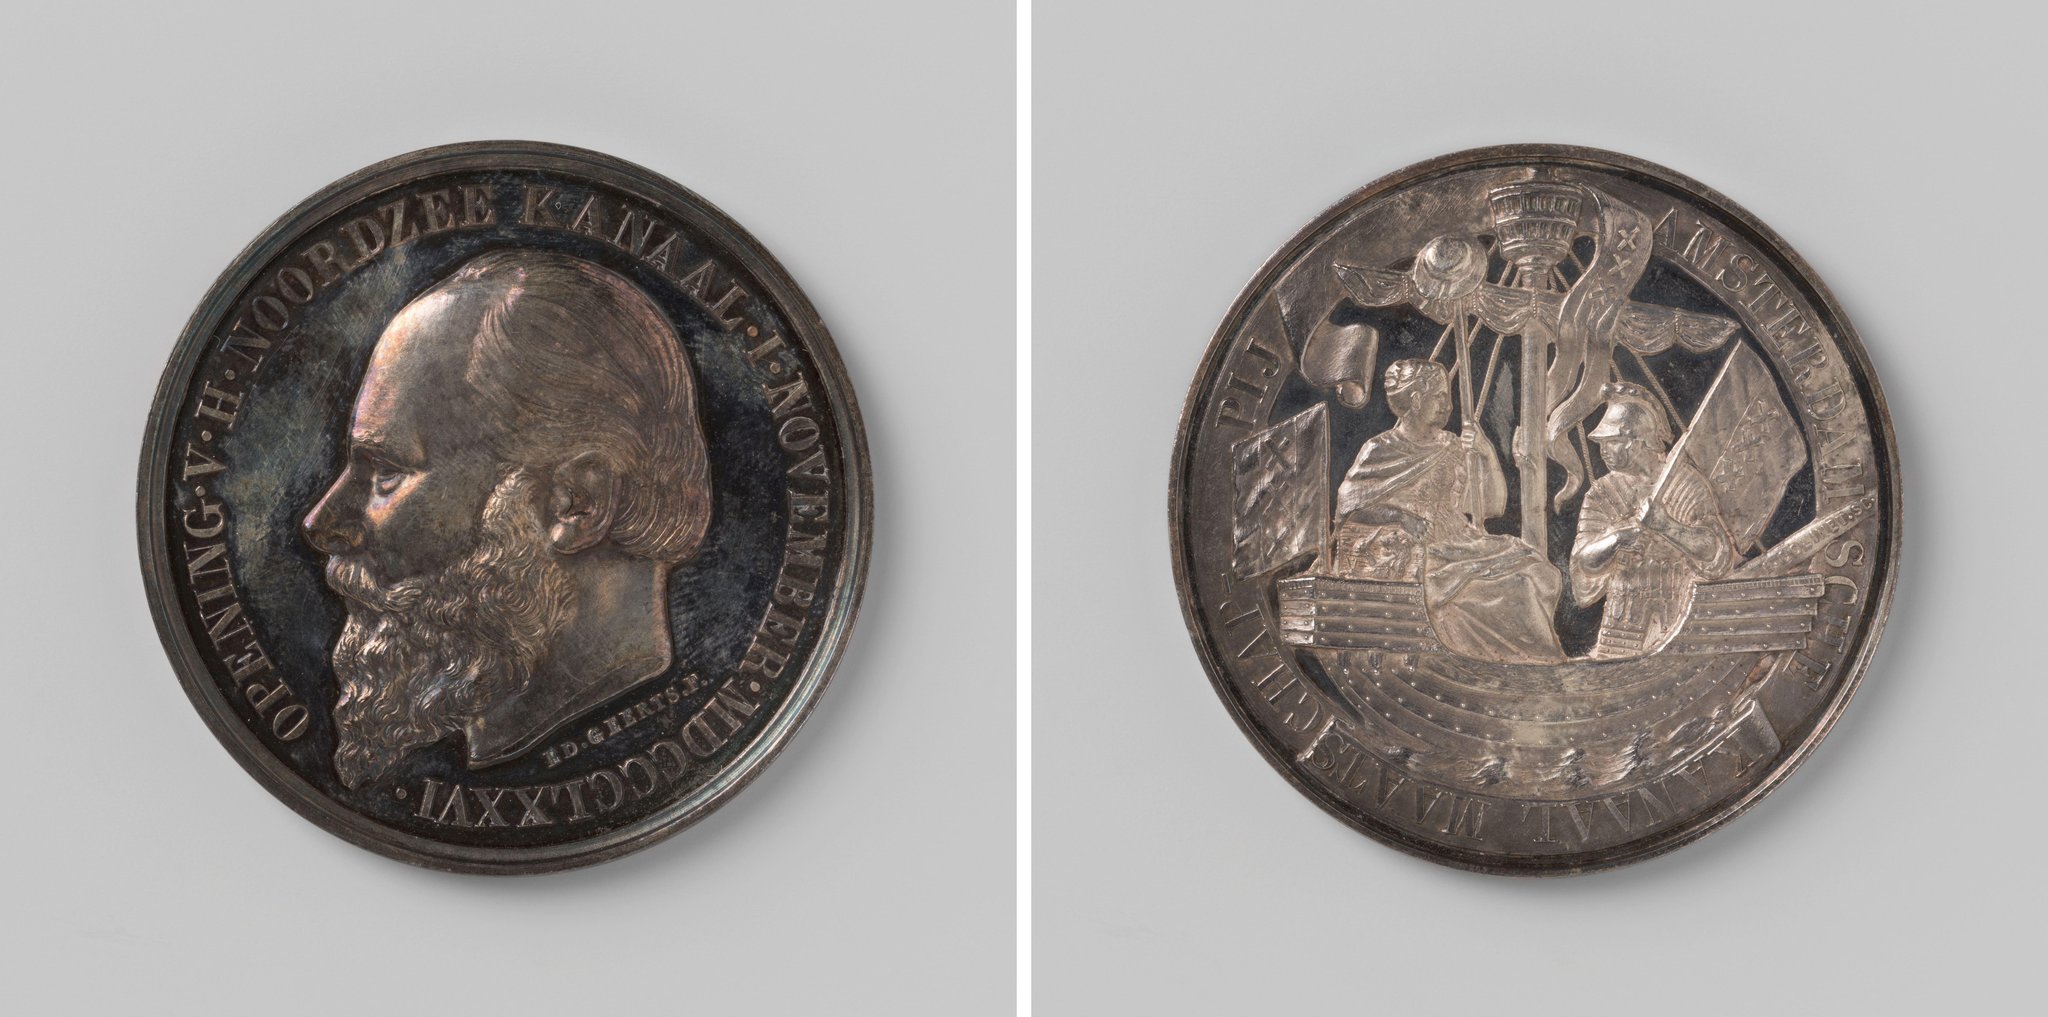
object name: history medal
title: Opening van het Noordzeekanaal, ter ere van Willem III, koning der Nederlanden, penning geslagen op last van de Amsterdamsche Kanaal Maatschappij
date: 1876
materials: silver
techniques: striking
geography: brussels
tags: brussels, willem iii (koning der nederlanden)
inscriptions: : ‘AMSTERDAMSCHE KANAAL MAATSCHAPPIJ’, signature: ‘ED. GEERTS . F.’, : ‘OPENING . V.H. NOORDZEEKANAAL . I . NOVEMBER . MDCCCLXXVI’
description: Tweezijdige zilveren penning. Voorzijde: borststuk van Willem III binnen omschrift. Keerzijde: vrouw met vrijheidshoed op lans en gehelmde vrouw met vaandel, zittend in boot: het Amsterdamse koggeschip, binnen wimpel met opschrift. Rood leren etui bijbehorend.